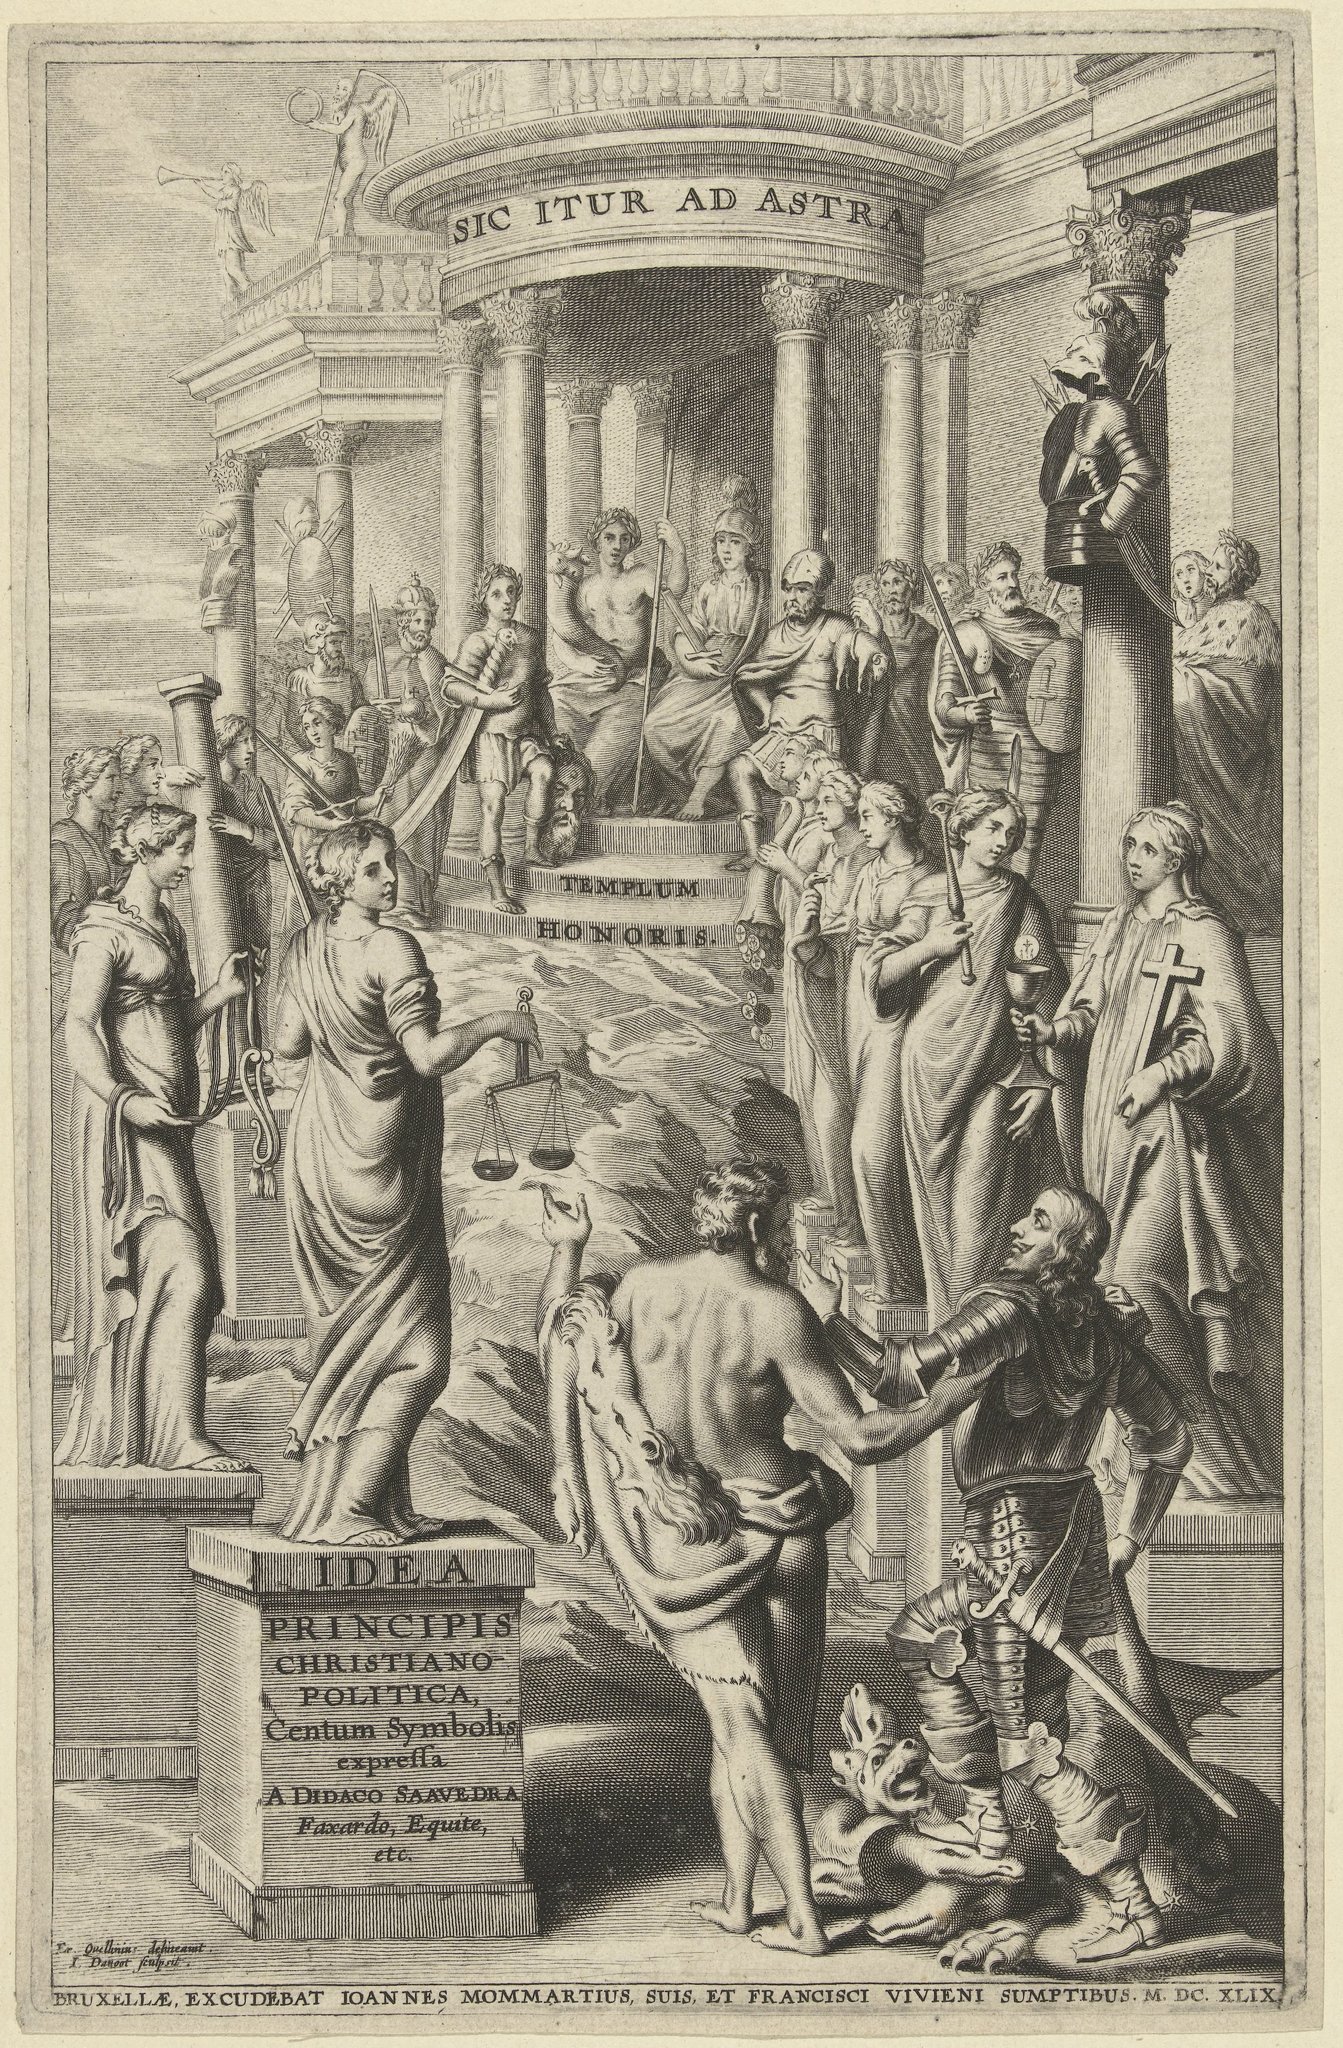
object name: print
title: Hercules leidt man langs personificaties van deugden naar tempel voor eeuwige roem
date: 1649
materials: paper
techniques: engraving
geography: brussels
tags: (story of) hercules (heracles), the seven virtues (symbolized), honour, glory; 'ampiezza della gloria', 'gloria', 'gloria de prencipi', 'gloria & honore', 'honore', 'sublimatà della gloria' (ripa)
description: Hercules leidt een man langs personificaties van deugden naar tempel voor eeuwige roem. De man, een heerser, draagt een harnas en vertrapt met zijn voeten een veelkoppige draak, in zijn hand houdt hij een knots. Deugden staan met attributen op sokkels langs een pad dat omhoog leidt naar een tempel waar David met het hoofd van Goliath en andere bijbelse helden wachten en Minerva op een troon zit. Opschrift op het fries van de tempel sic itur ad astra. De symboliek verwijst naar de inhoud van de uitgave waarin de auteur met emblemen aanbevelingen doet voor een heerser, een prins, om met behulp van deugden het juiste politieke leiderschap te tonen.